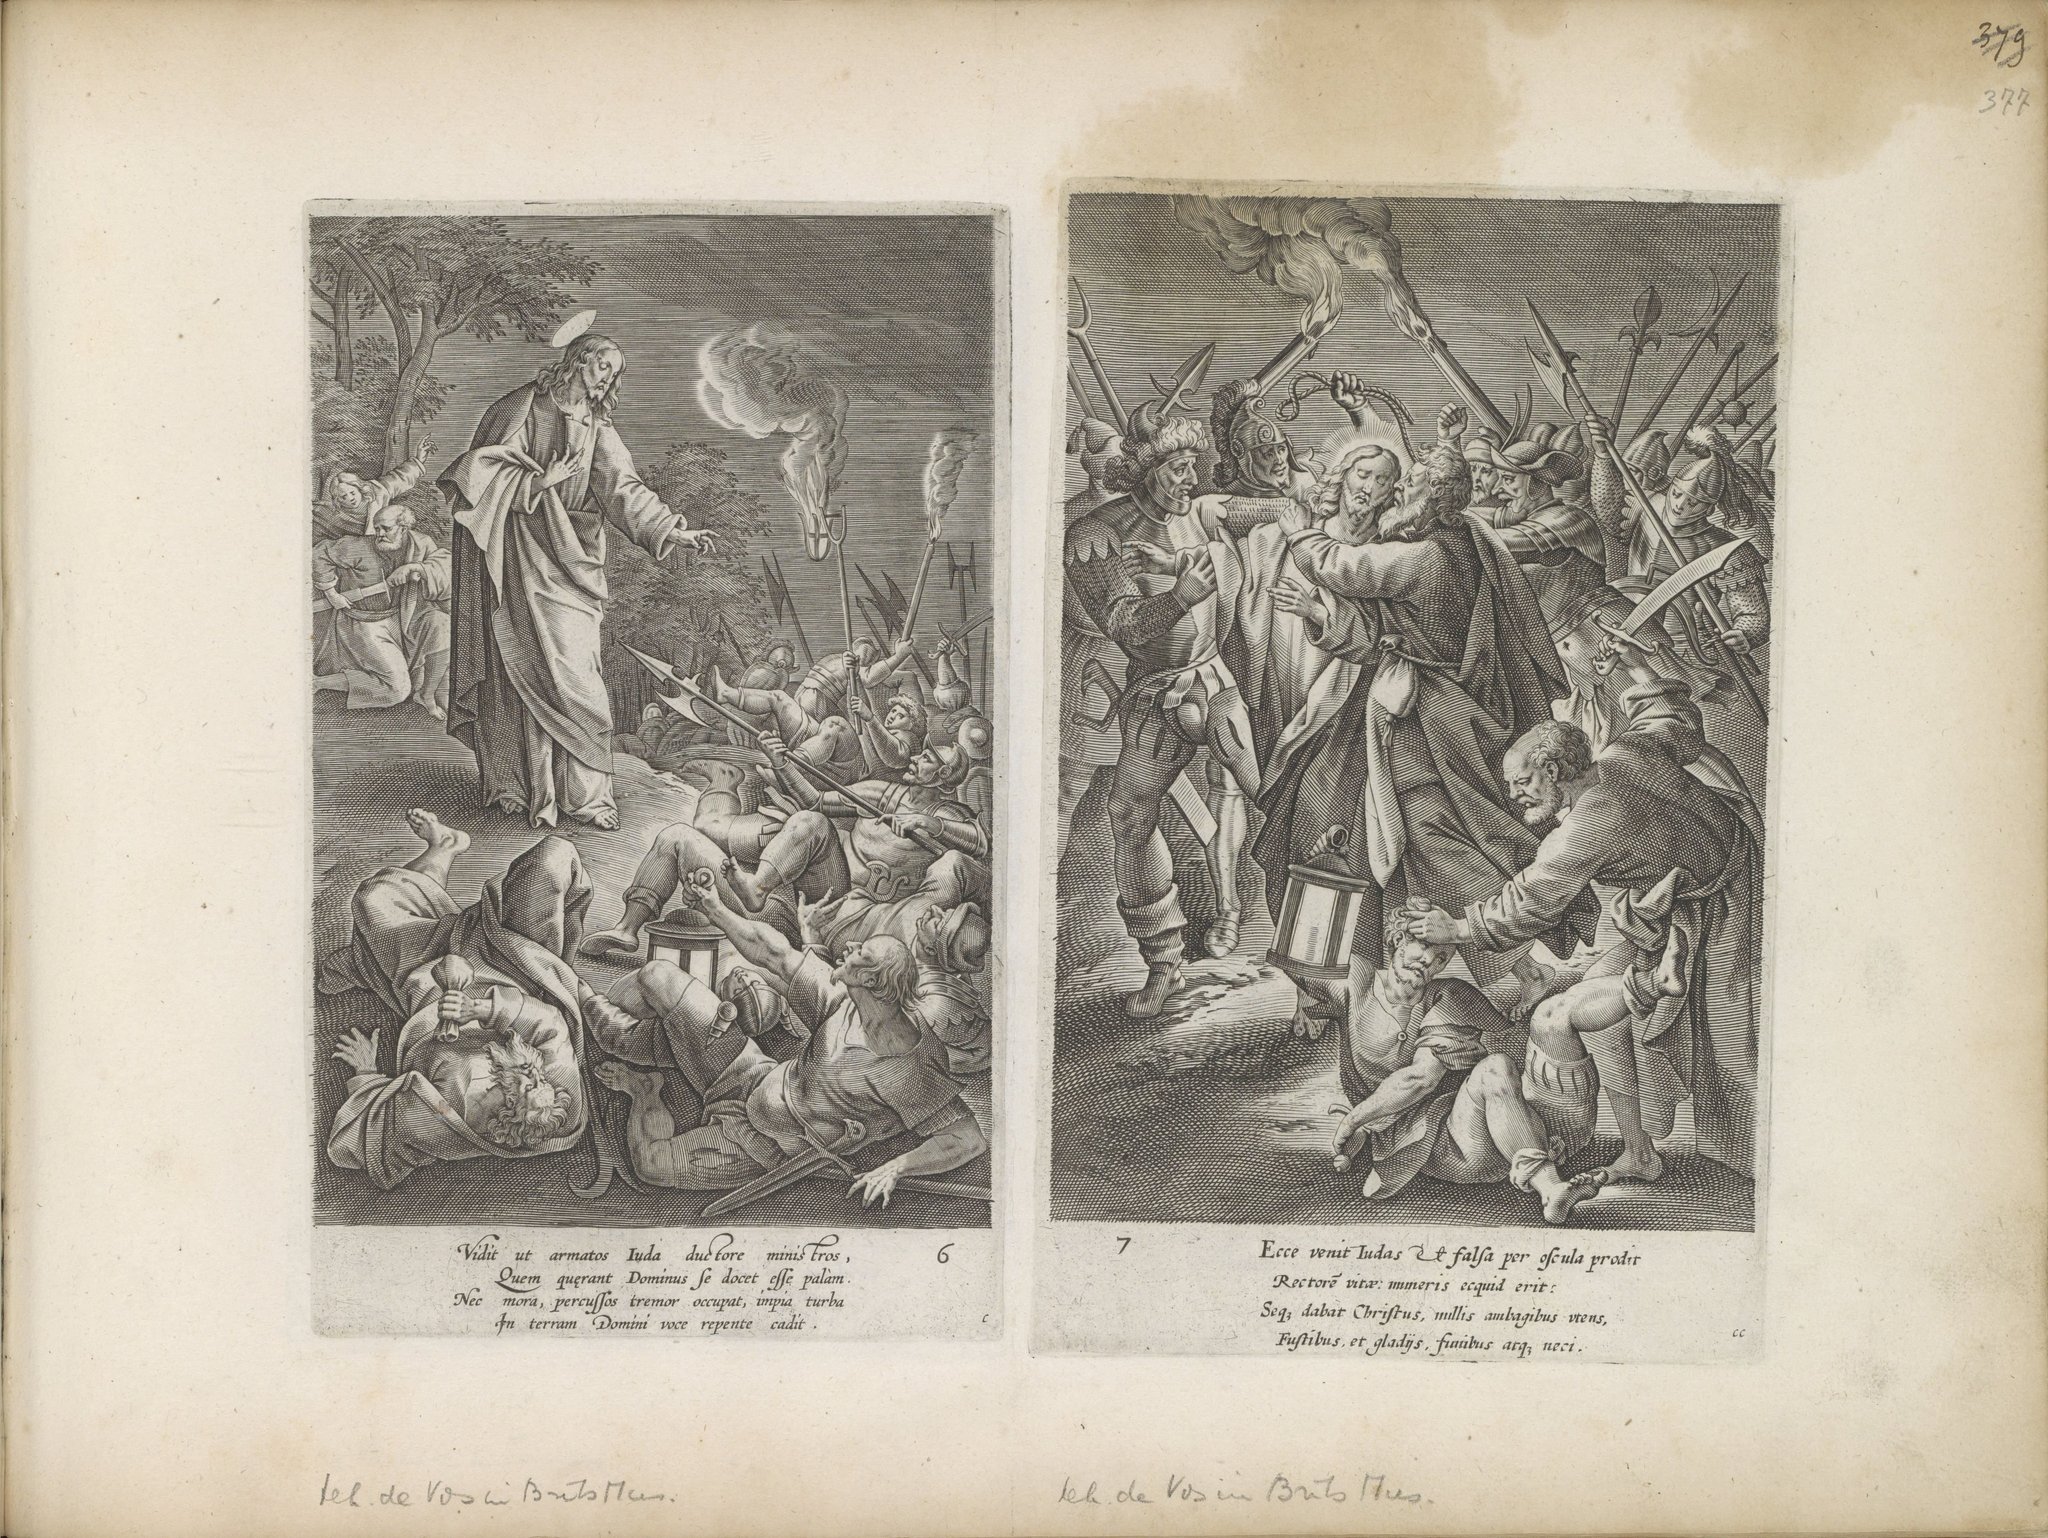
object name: album leaf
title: Soldaten die Christus omsingelen vallen op de grond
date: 1585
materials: paper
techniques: engraving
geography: amsterdam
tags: peter draws his sword and cuts off malchus' ear, christ makes himself known; the soldiers fall to the ground ~ the kiss of judas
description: Christus maakt zichzelf bekend in de hof van Getsemane. Judas, zijn verrader, en de soldaten deinzen achteruit en vallen op de grond. Op de achtergrond trekt Simon Petrus zijn zwaard om het rechteroor van Malchus af te slaan. Onder de voorstelling een vierregelig vers in het Latijn. Rechtsonder de letter: c. Deze prent maakt deel uit van een album.